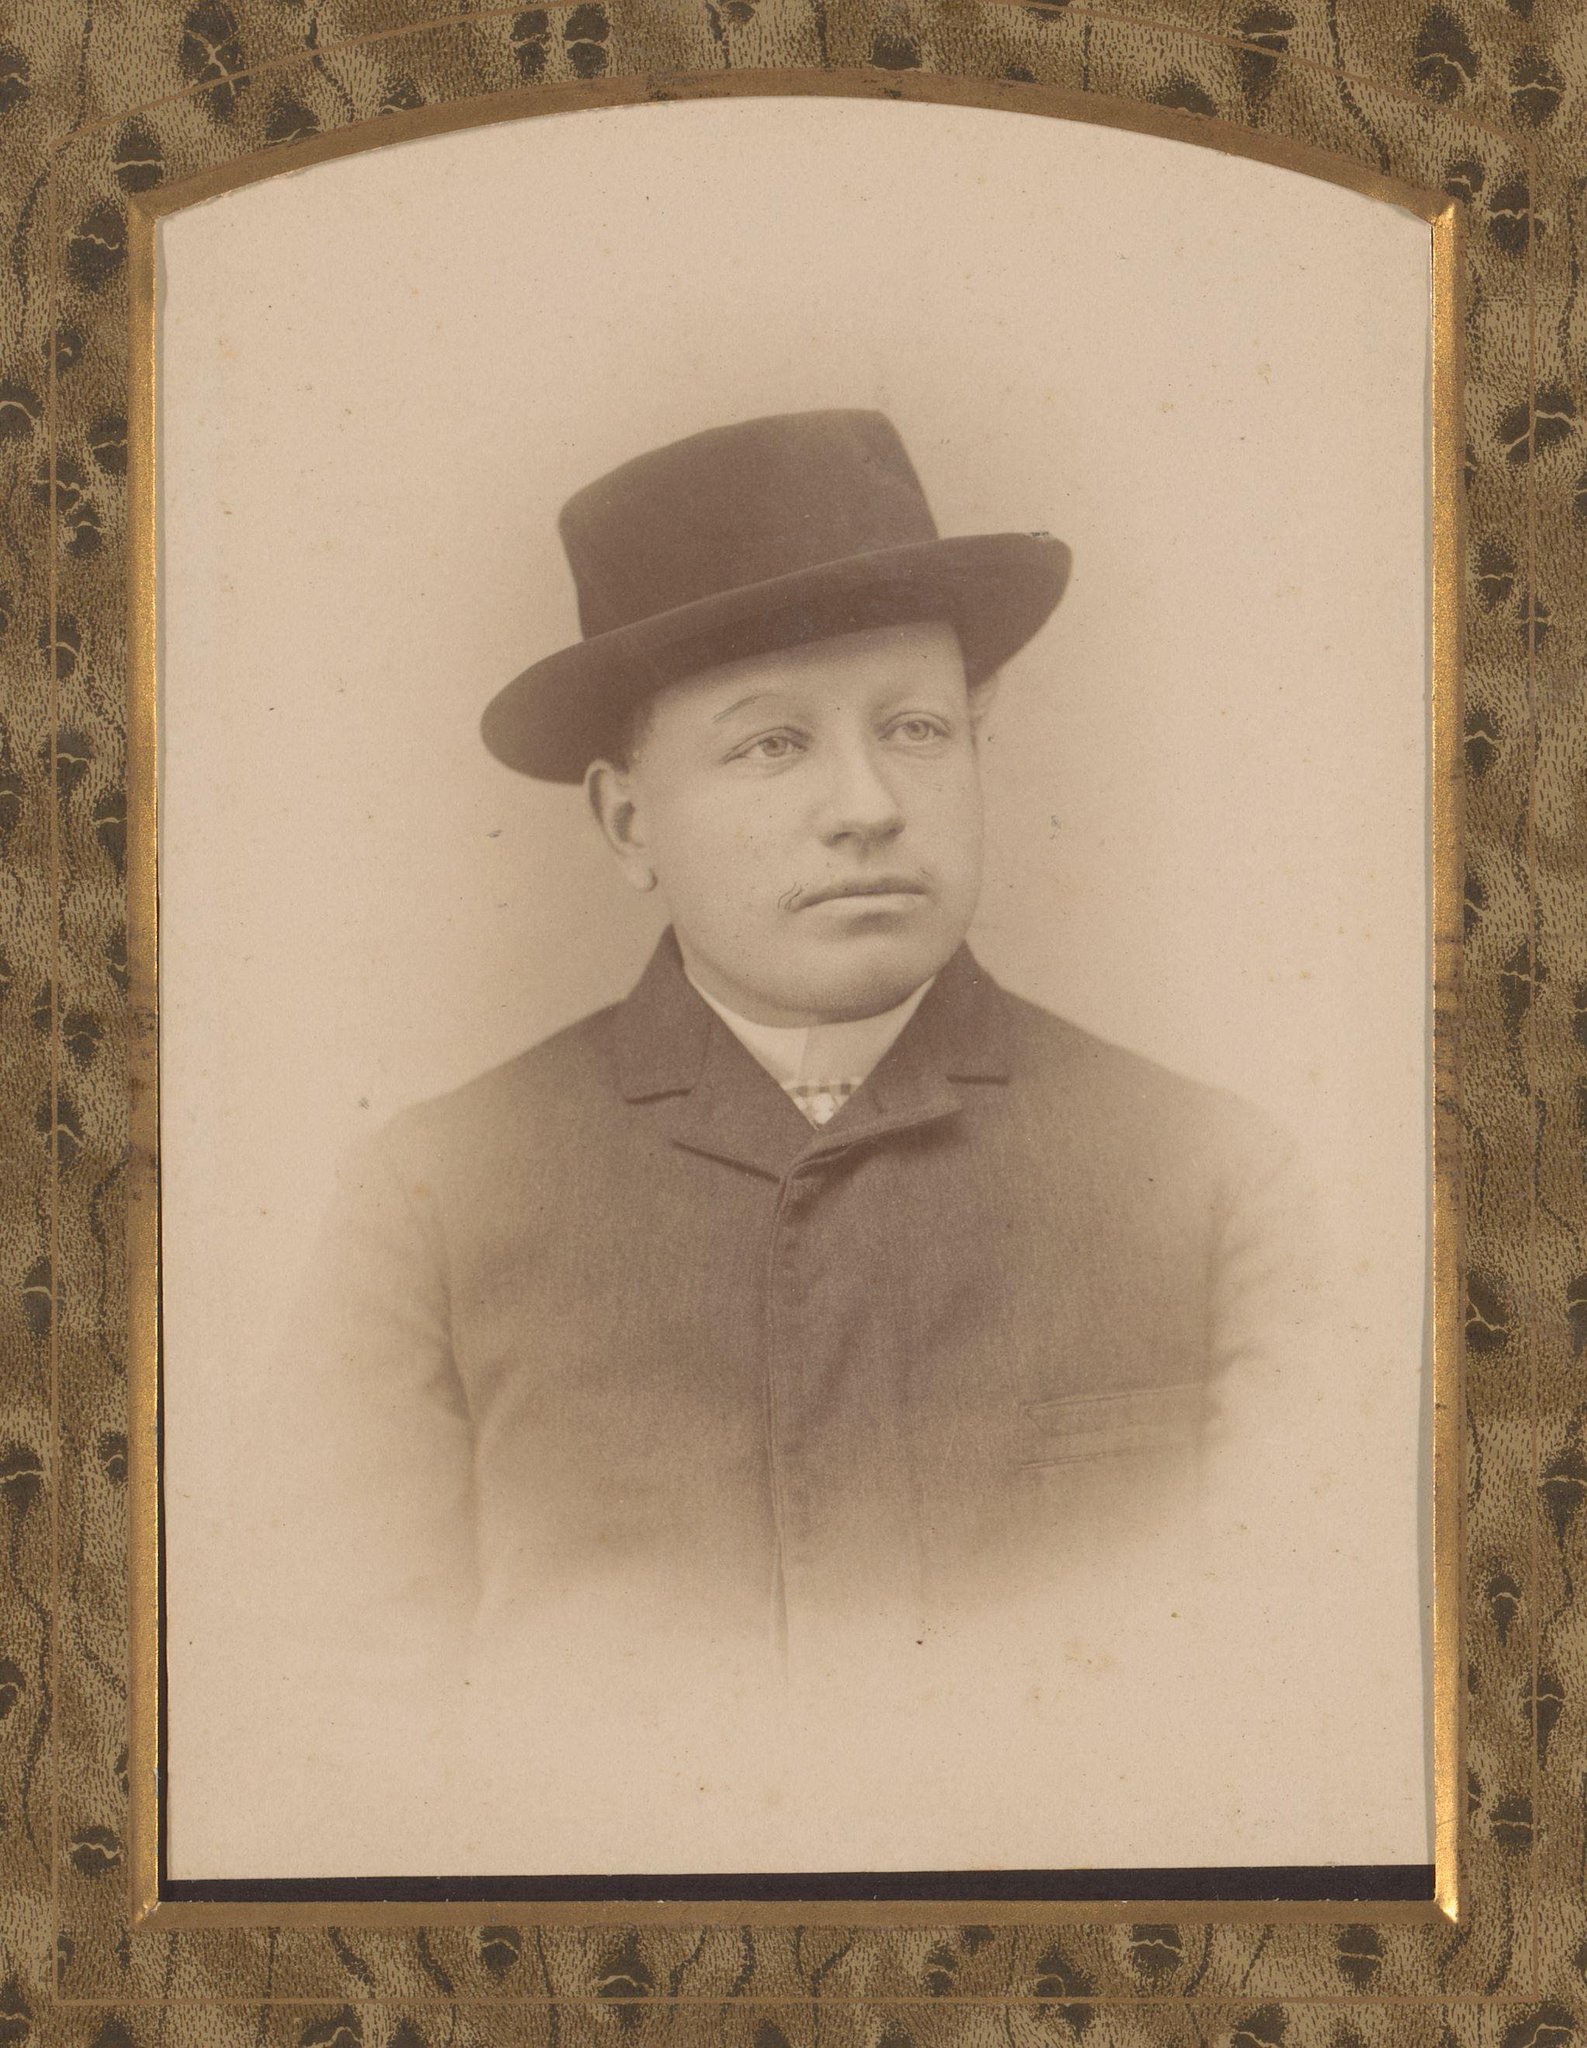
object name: album leaf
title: Portret van een man met hoed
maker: a. kit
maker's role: fotograaf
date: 1880-1900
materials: cardboard, photographic support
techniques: albumen print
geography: indo-china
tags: historical persons, head-gear: hat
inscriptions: inscription: ‘A-KIT./ PHOTOGRAPHIE ET PEINTRE DE/ PORTRAIT/ AU PREMIER/ No. 1, Rue de Chinois No. 1,/ HAIPHONG/ PRIX MODERES./ (...)’